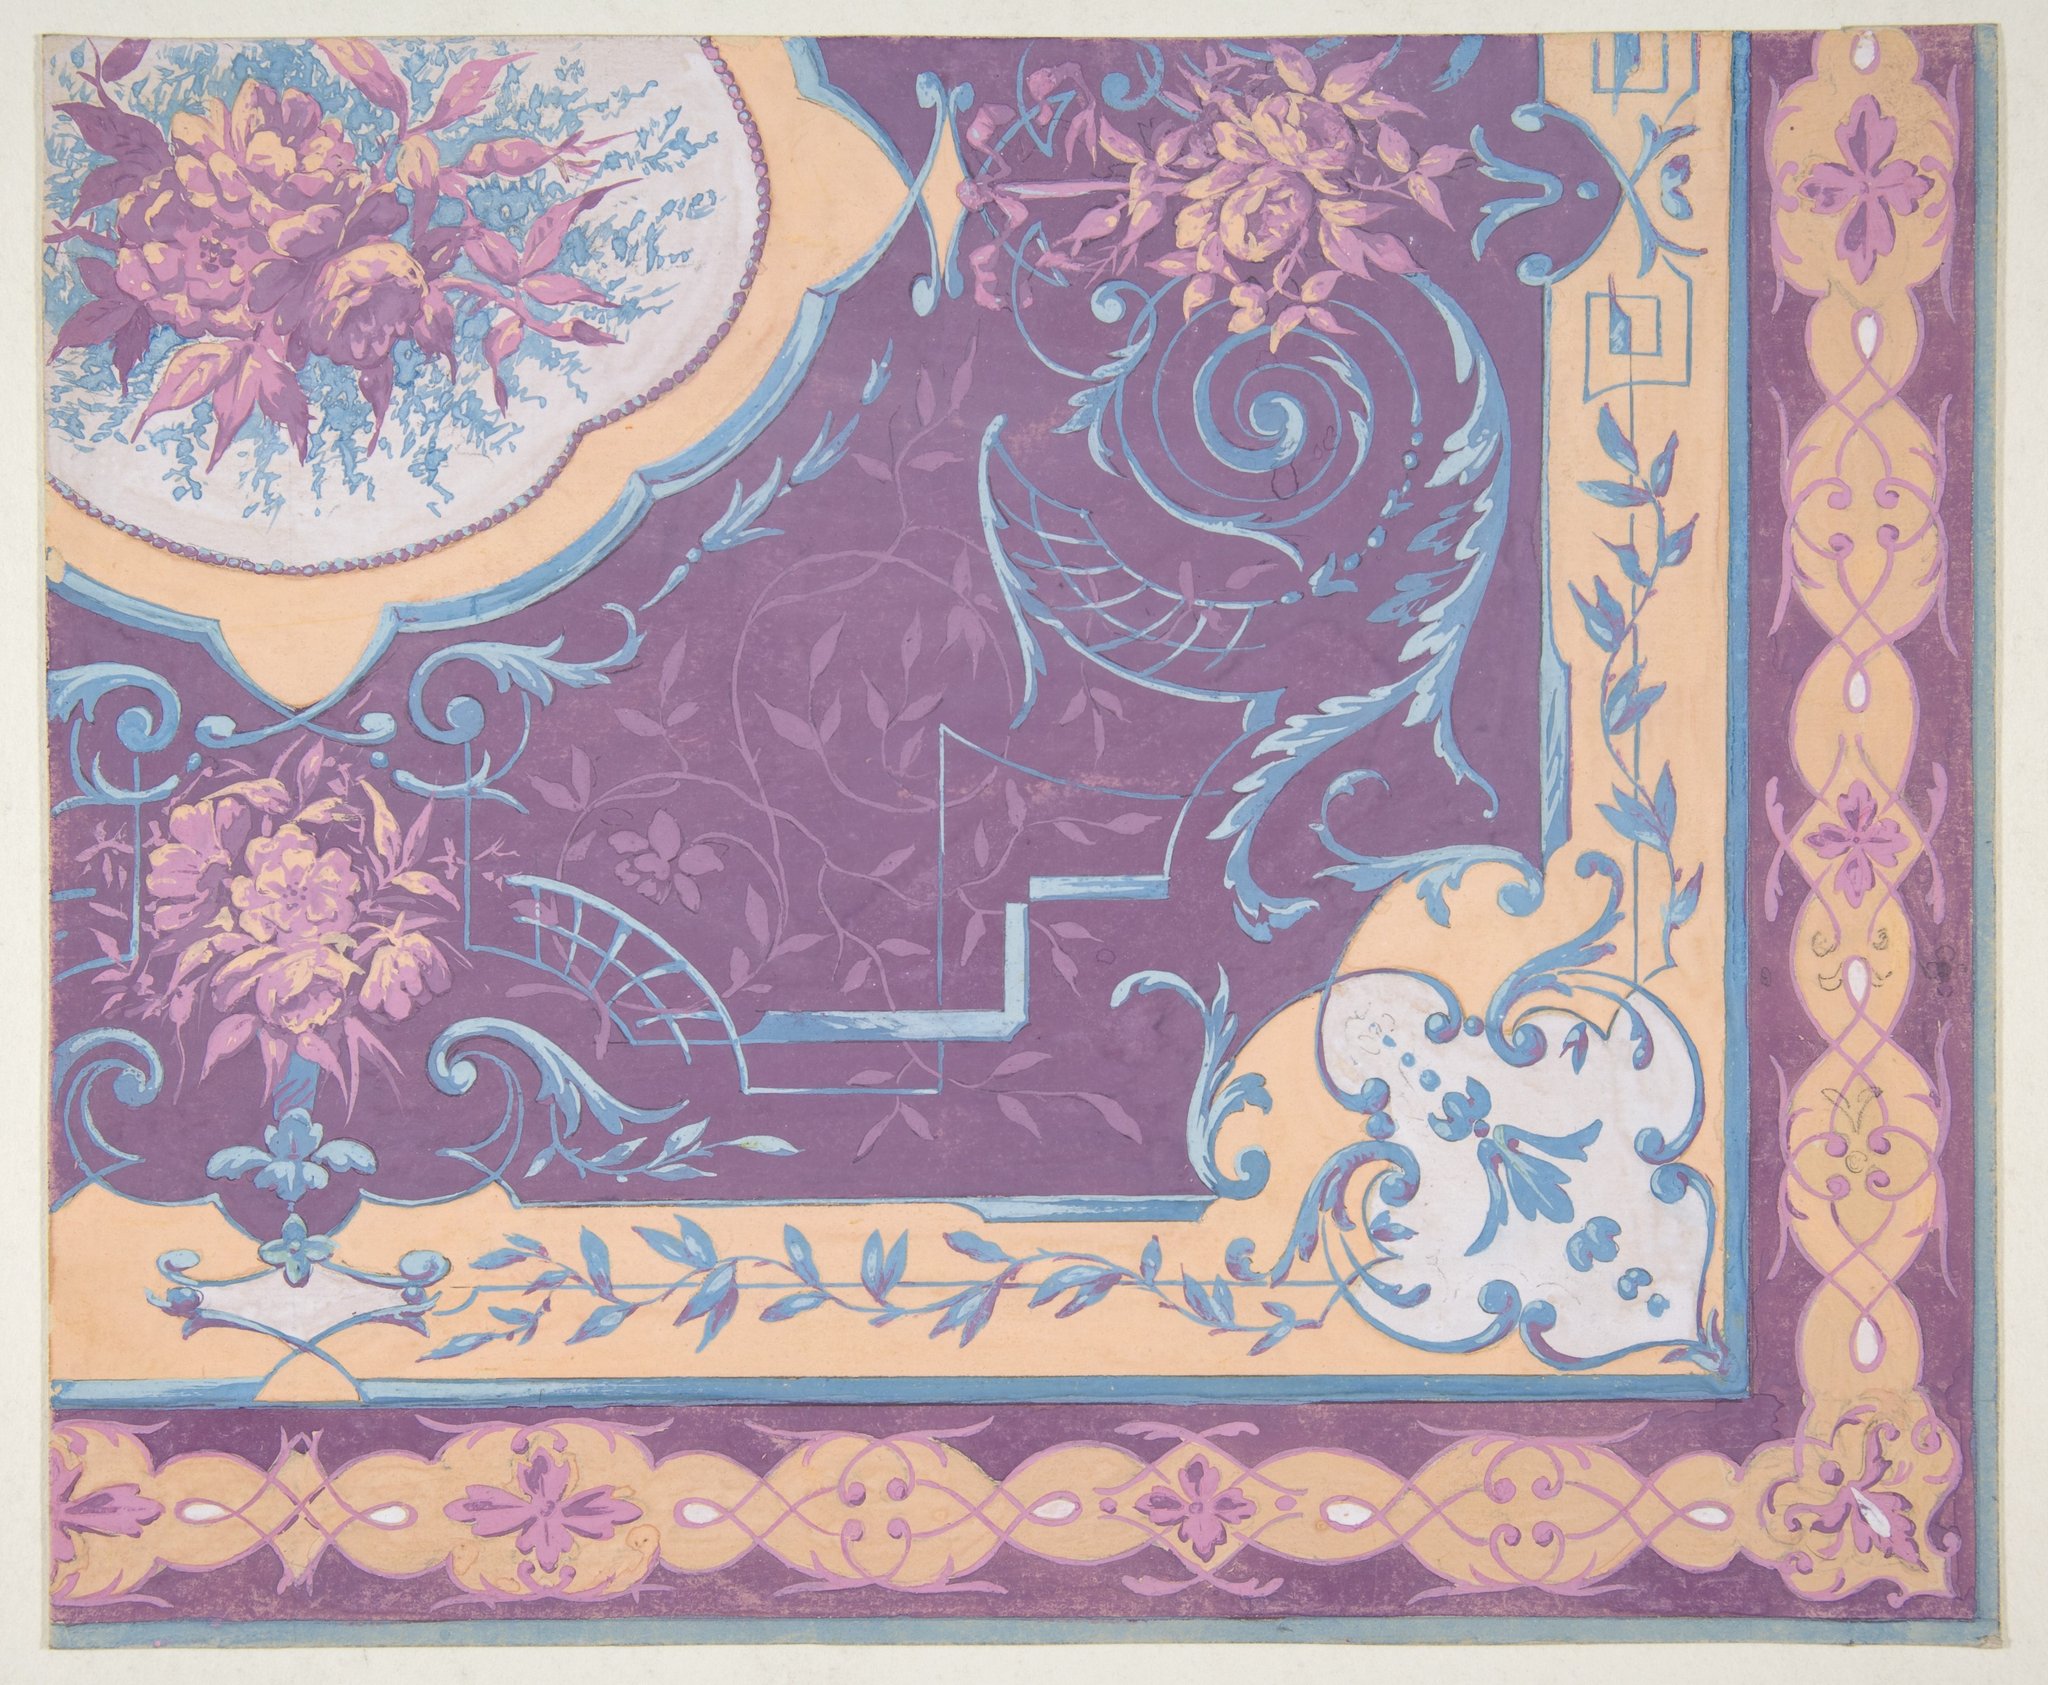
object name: drawing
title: Wallpaper design featuring bouquets of roses, strapwork, and rinceaux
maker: jules-edmond-charles lachaise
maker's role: artist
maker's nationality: french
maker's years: 1897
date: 1830-1897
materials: gouache, paper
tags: roses